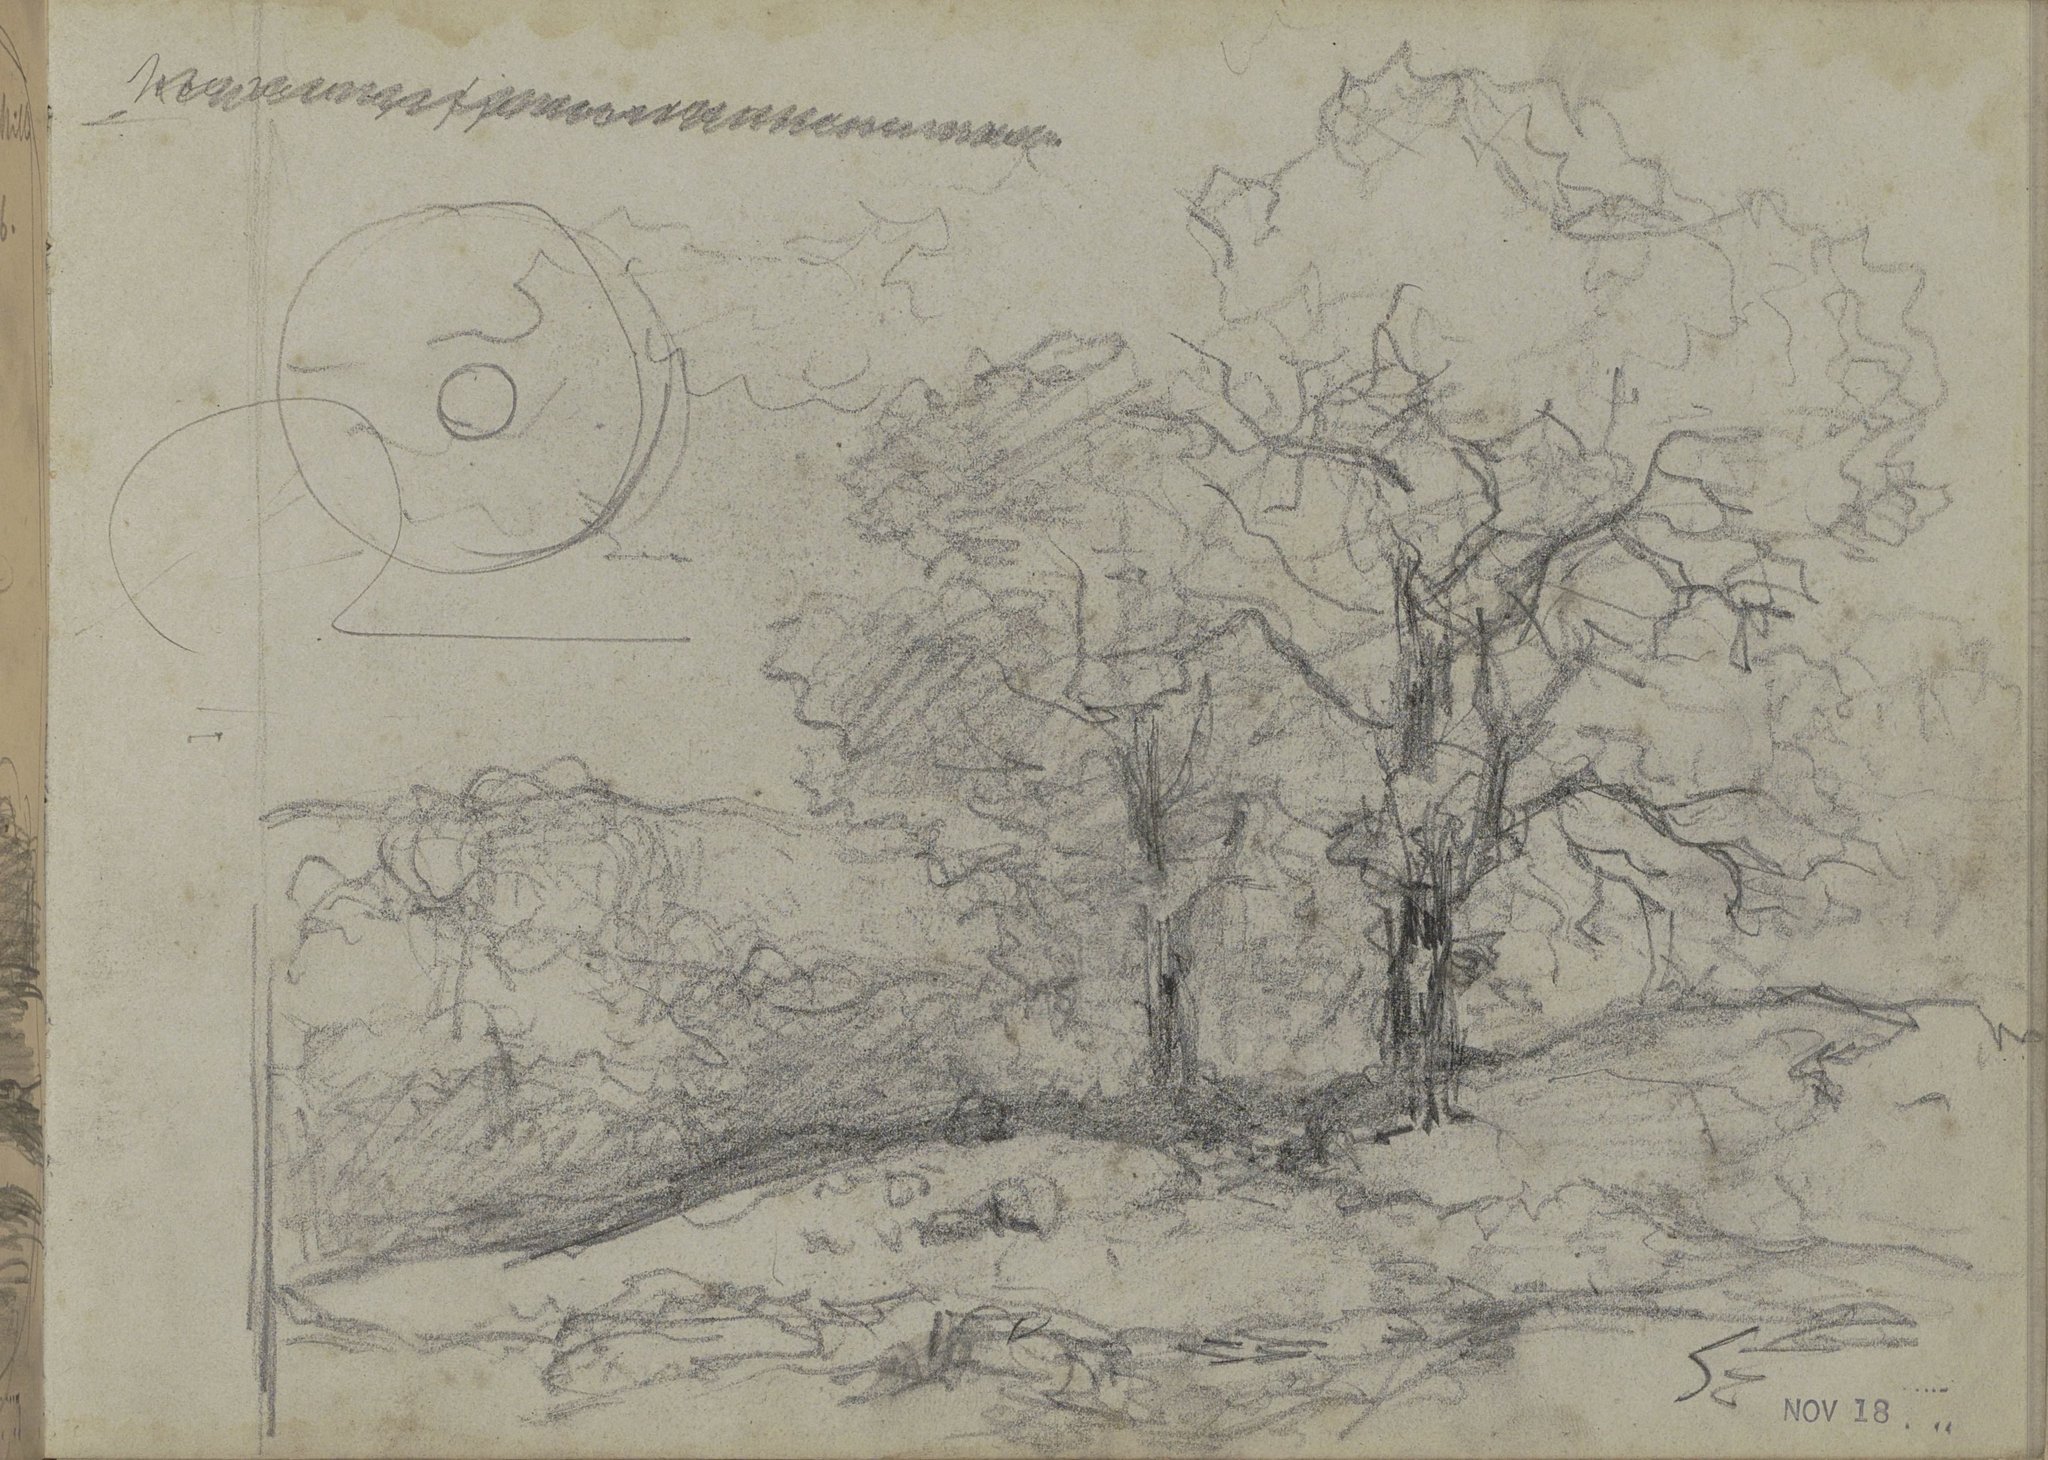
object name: sketchbook leaf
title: Landschap met bomen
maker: willem roelofs (i)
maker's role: draughtsman, painter, print maker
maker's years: 1822-1897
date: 1846-1851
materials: paper, pencil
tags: landscapes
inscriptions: date: ‘NOV 18 , ,,’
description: Blad 12 recto uit een schetsboek met 25 bladen.